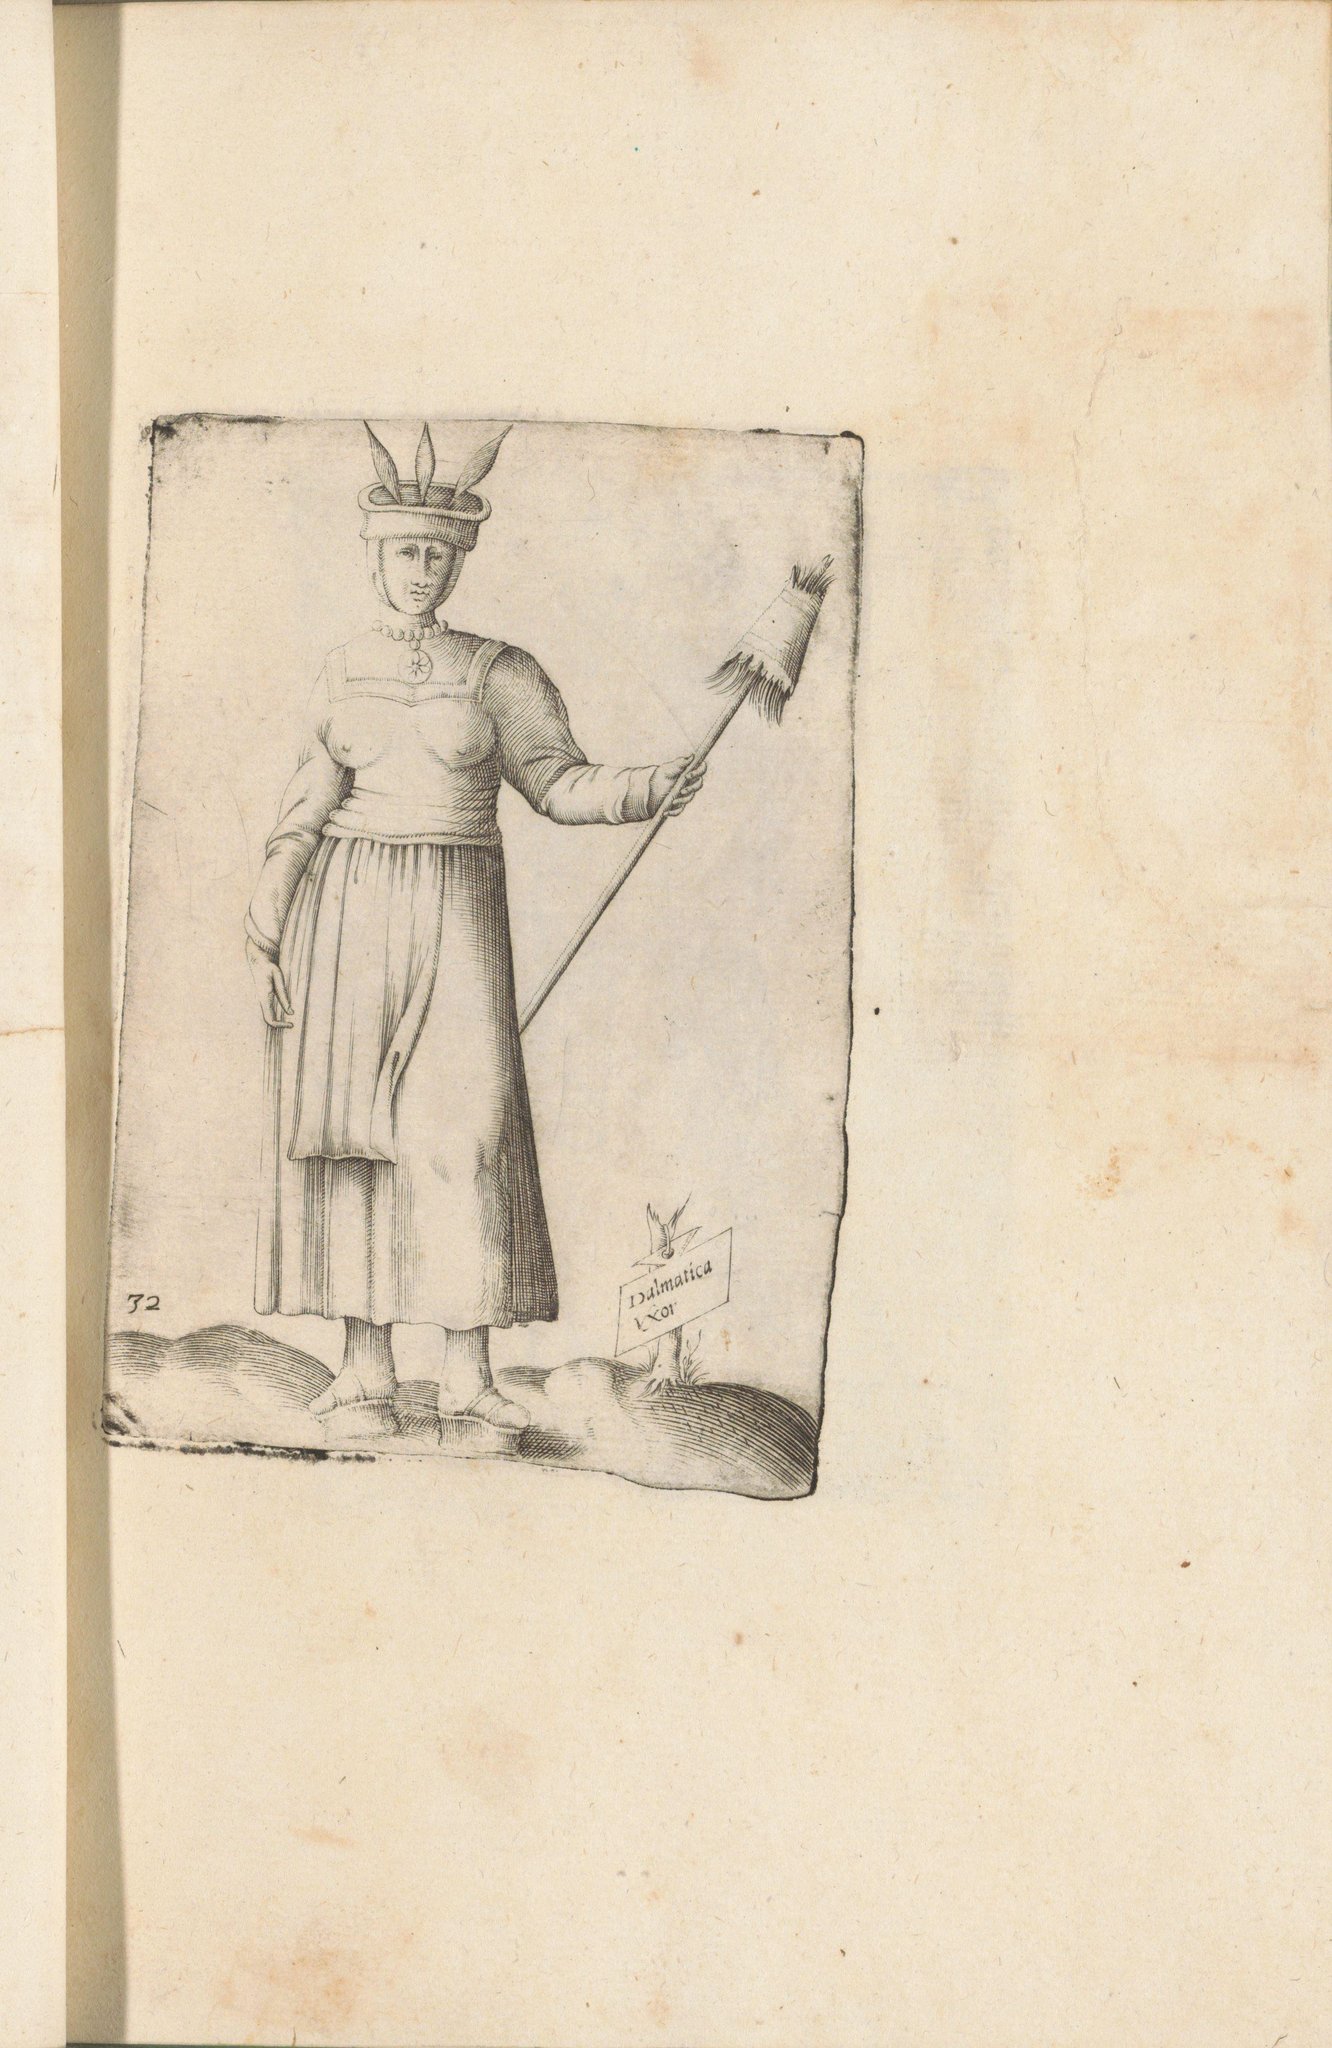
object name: costume print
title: Dalmatica uxor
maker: ferando bertelli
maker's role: print maker, publisher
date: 1569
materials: paper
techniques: engraving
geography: venice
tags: distaff, fashion plates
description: Vrouw uit Dalmatië, spinrokken in de hand. Op het hoofd een muts met drie veren. Onderdeel van het kostuumboek getiteld 'Omnium fere gentium nostrae aetatis habitus, nunquam ante hac aediti', Venetië 1569. Heruitgave uit 1569 van de eerste editie uit 1563.